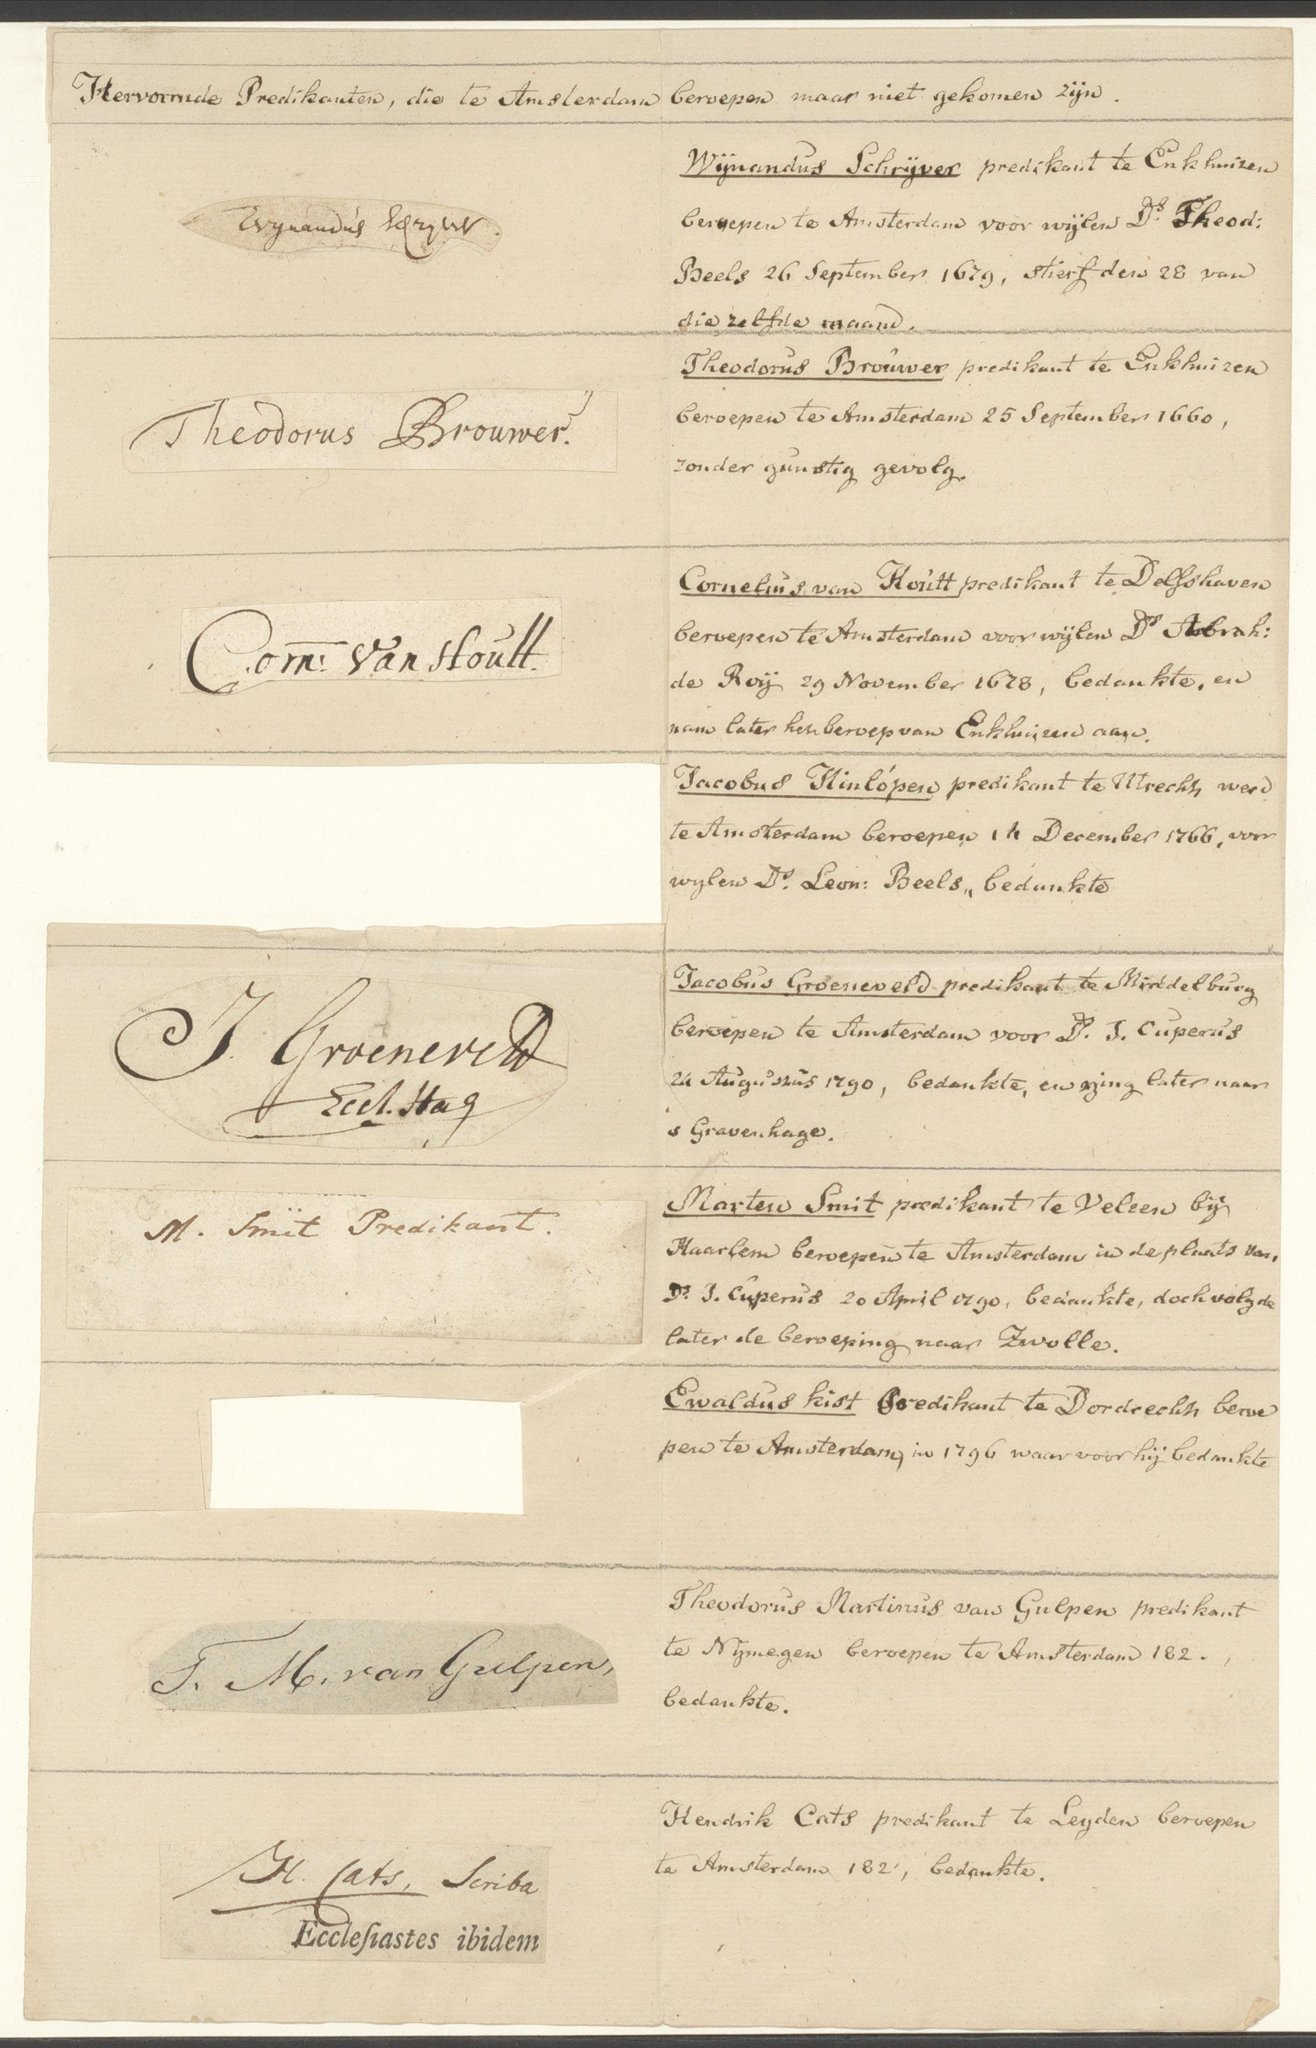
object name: text sheet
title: Hervormde Predikanten, die te Amsterdam beroepen maar niet gekomen zijn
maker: Anonymous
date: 1679-1829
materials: ink, paper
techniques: pen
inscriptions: stamp, collector's mark: Lugt 1641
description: Handtekeningen van Hervormde predikanten beroepen te Amsterdam. Alle predikanten hebben bedankt en zijn niet gekomen toen zij beroepen werden in Amsterdam. Onderwerpsrubrieken binnen de Atlas Zeden en Gewoonten: Godsdienst, Ned. Hervormden, (Oudtijds Gereformeerden).